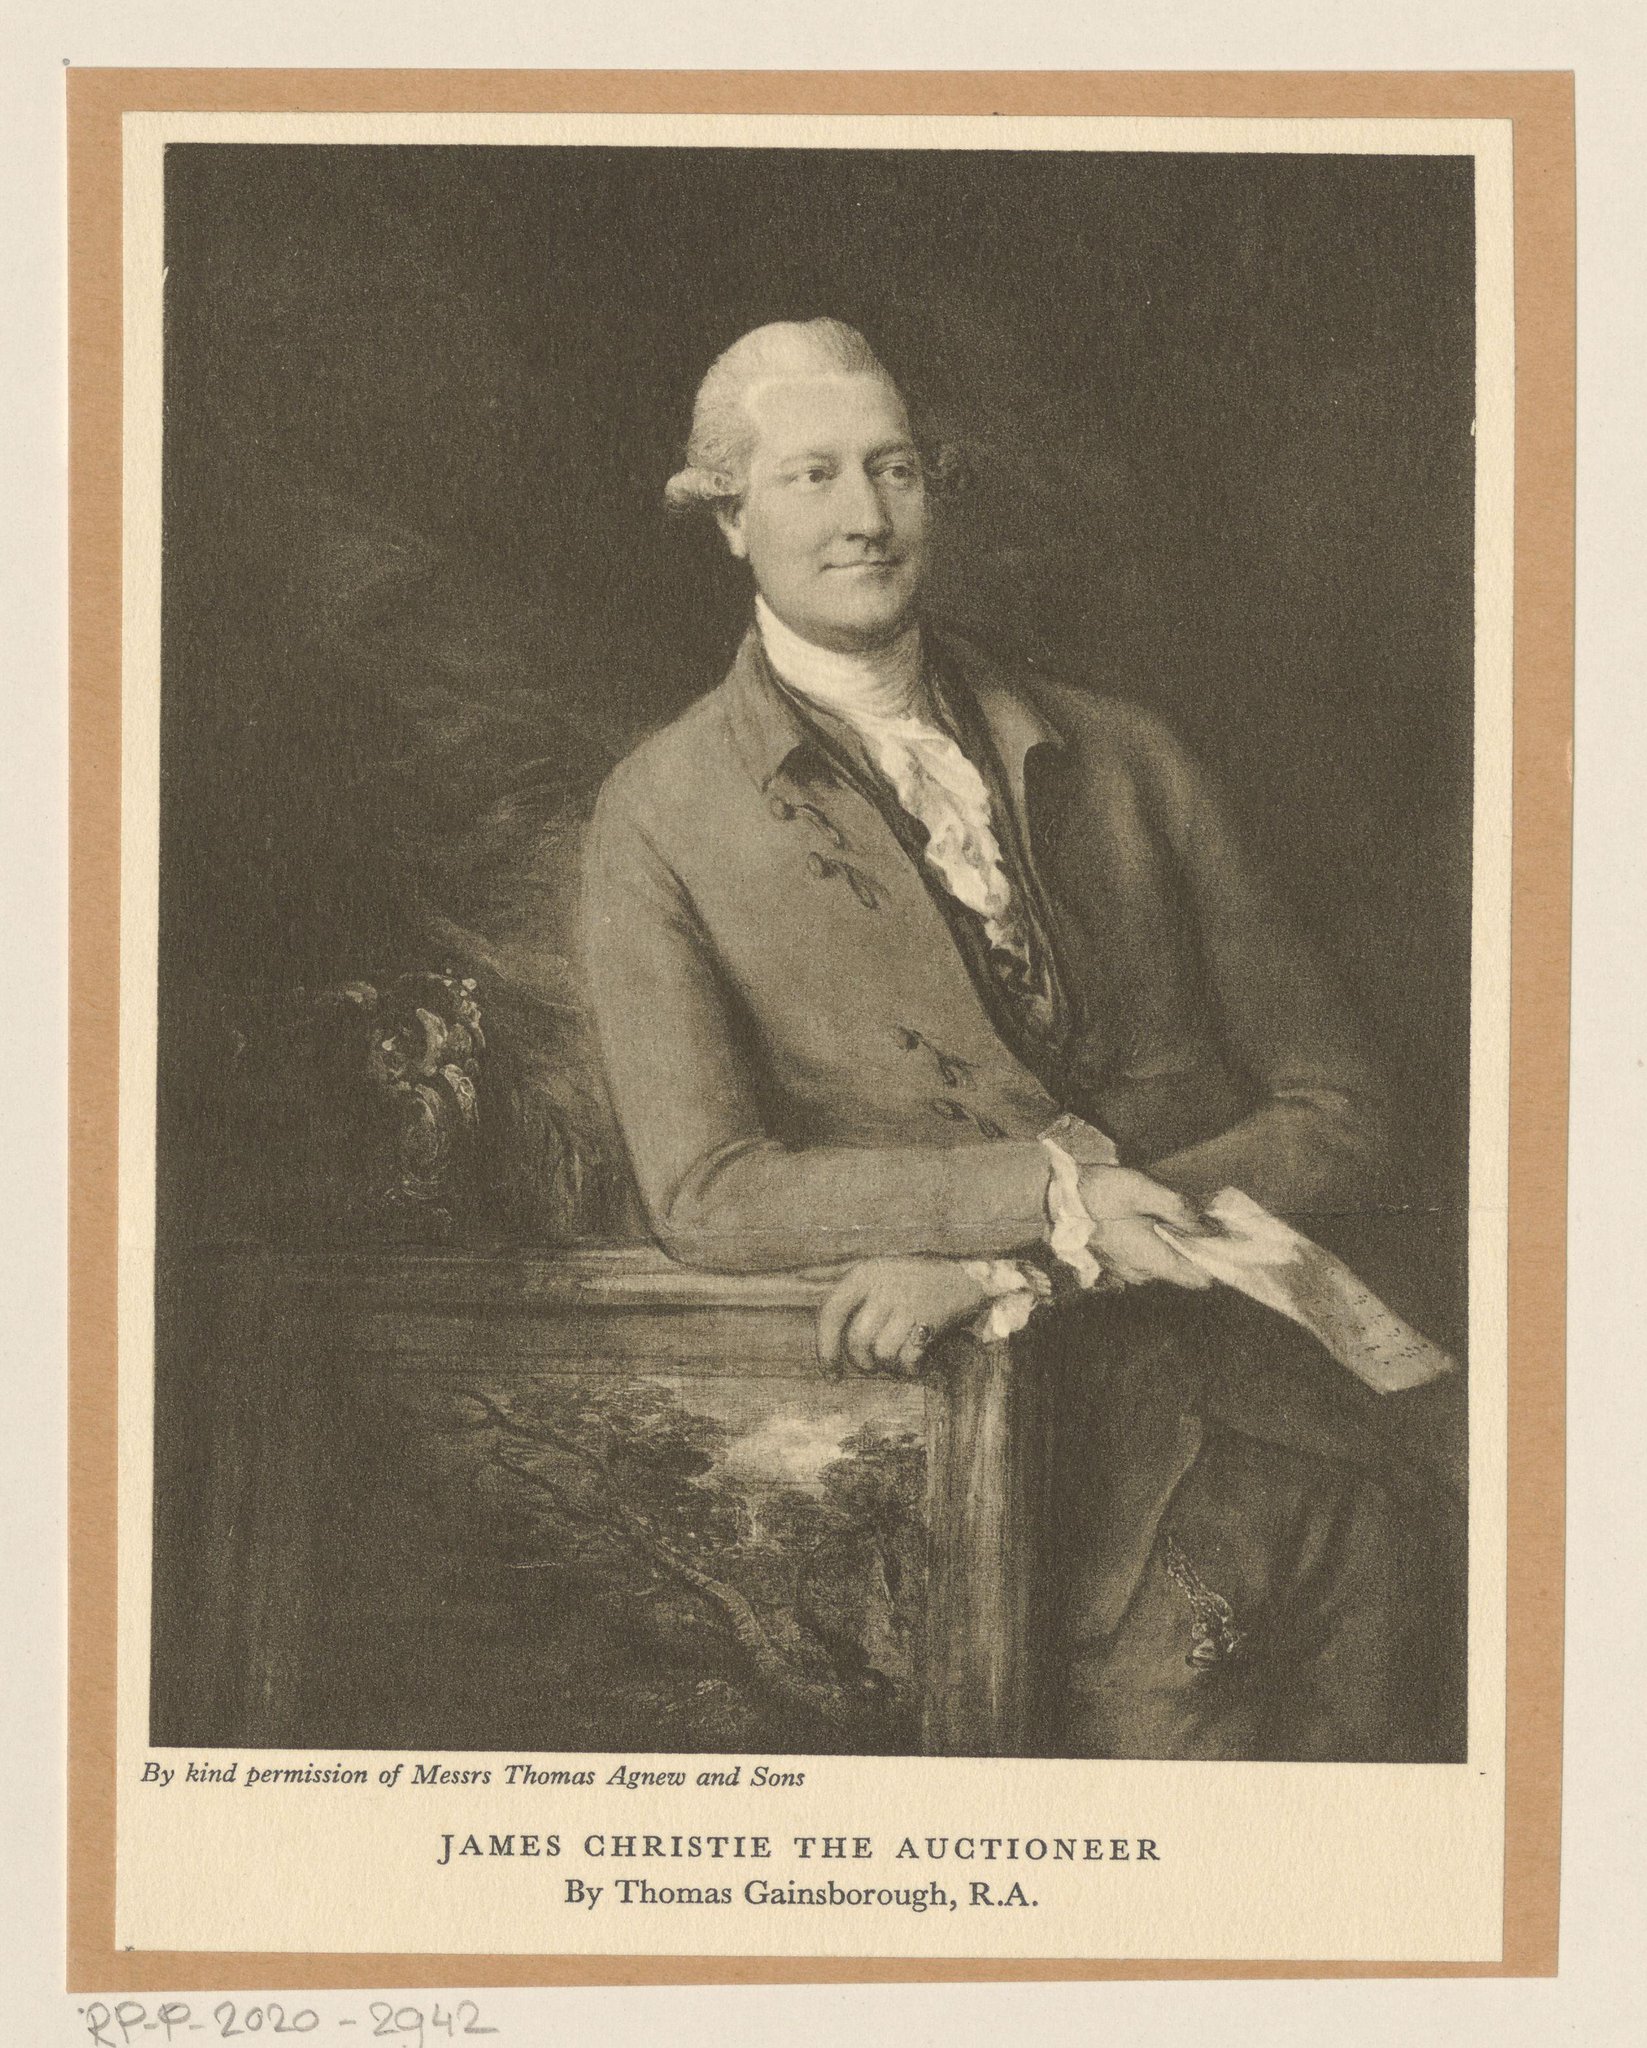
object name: photomechanical print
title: Portret van James Christie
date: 1860-1949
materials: paper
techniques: photoaquatint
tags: historical persons